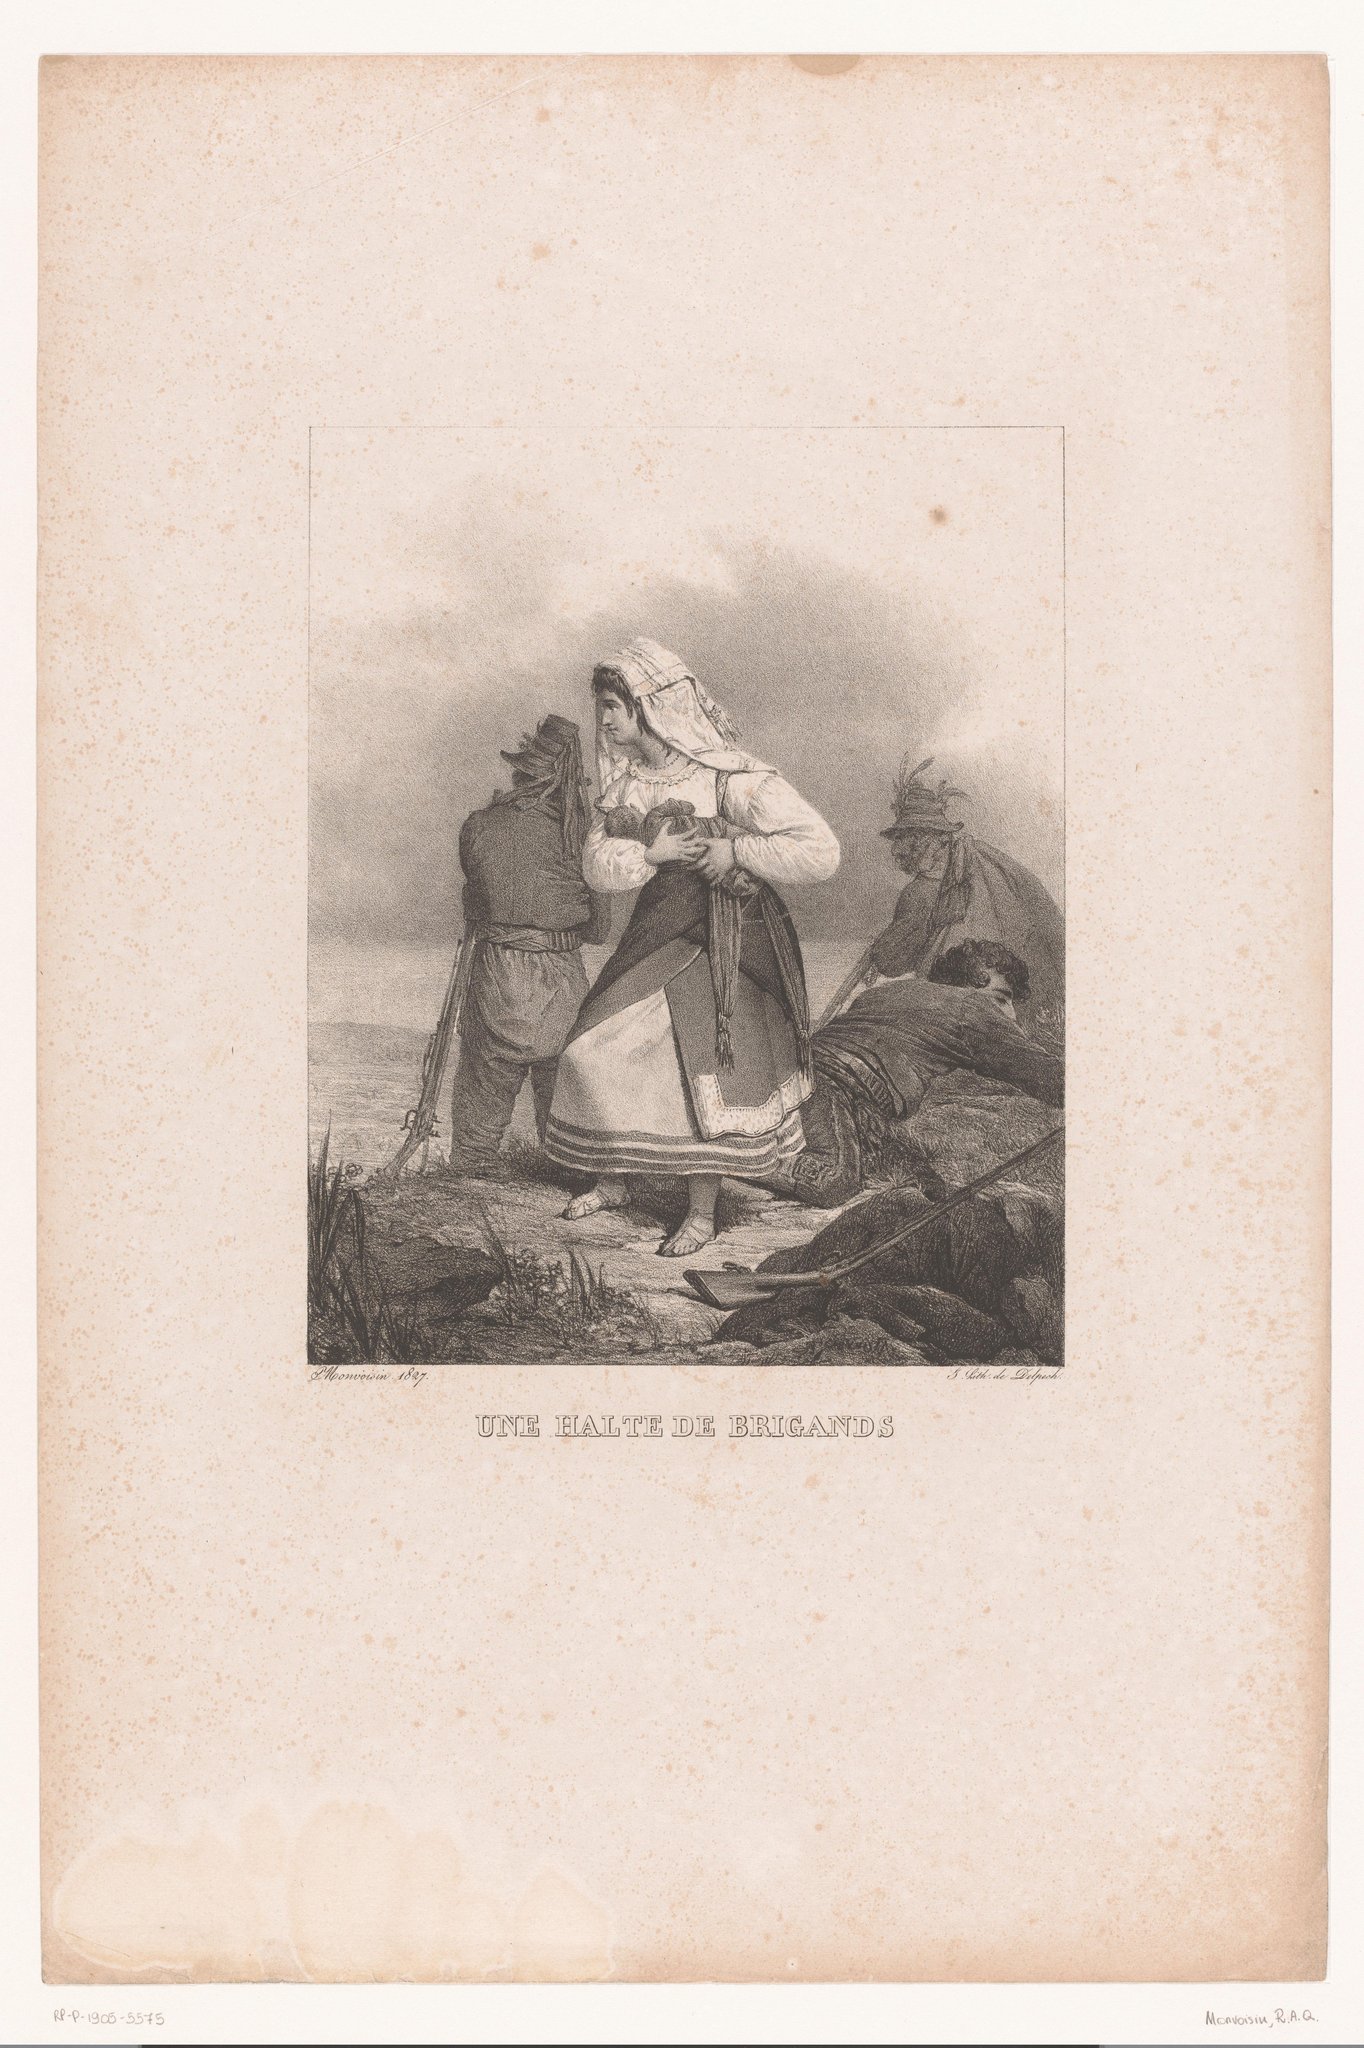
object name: print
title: Roversbende neemt pauze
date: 1827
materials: paper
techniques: lithograph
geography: paris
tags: robbery - gg - female, robber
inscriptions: collector's mark: Lugt 2228